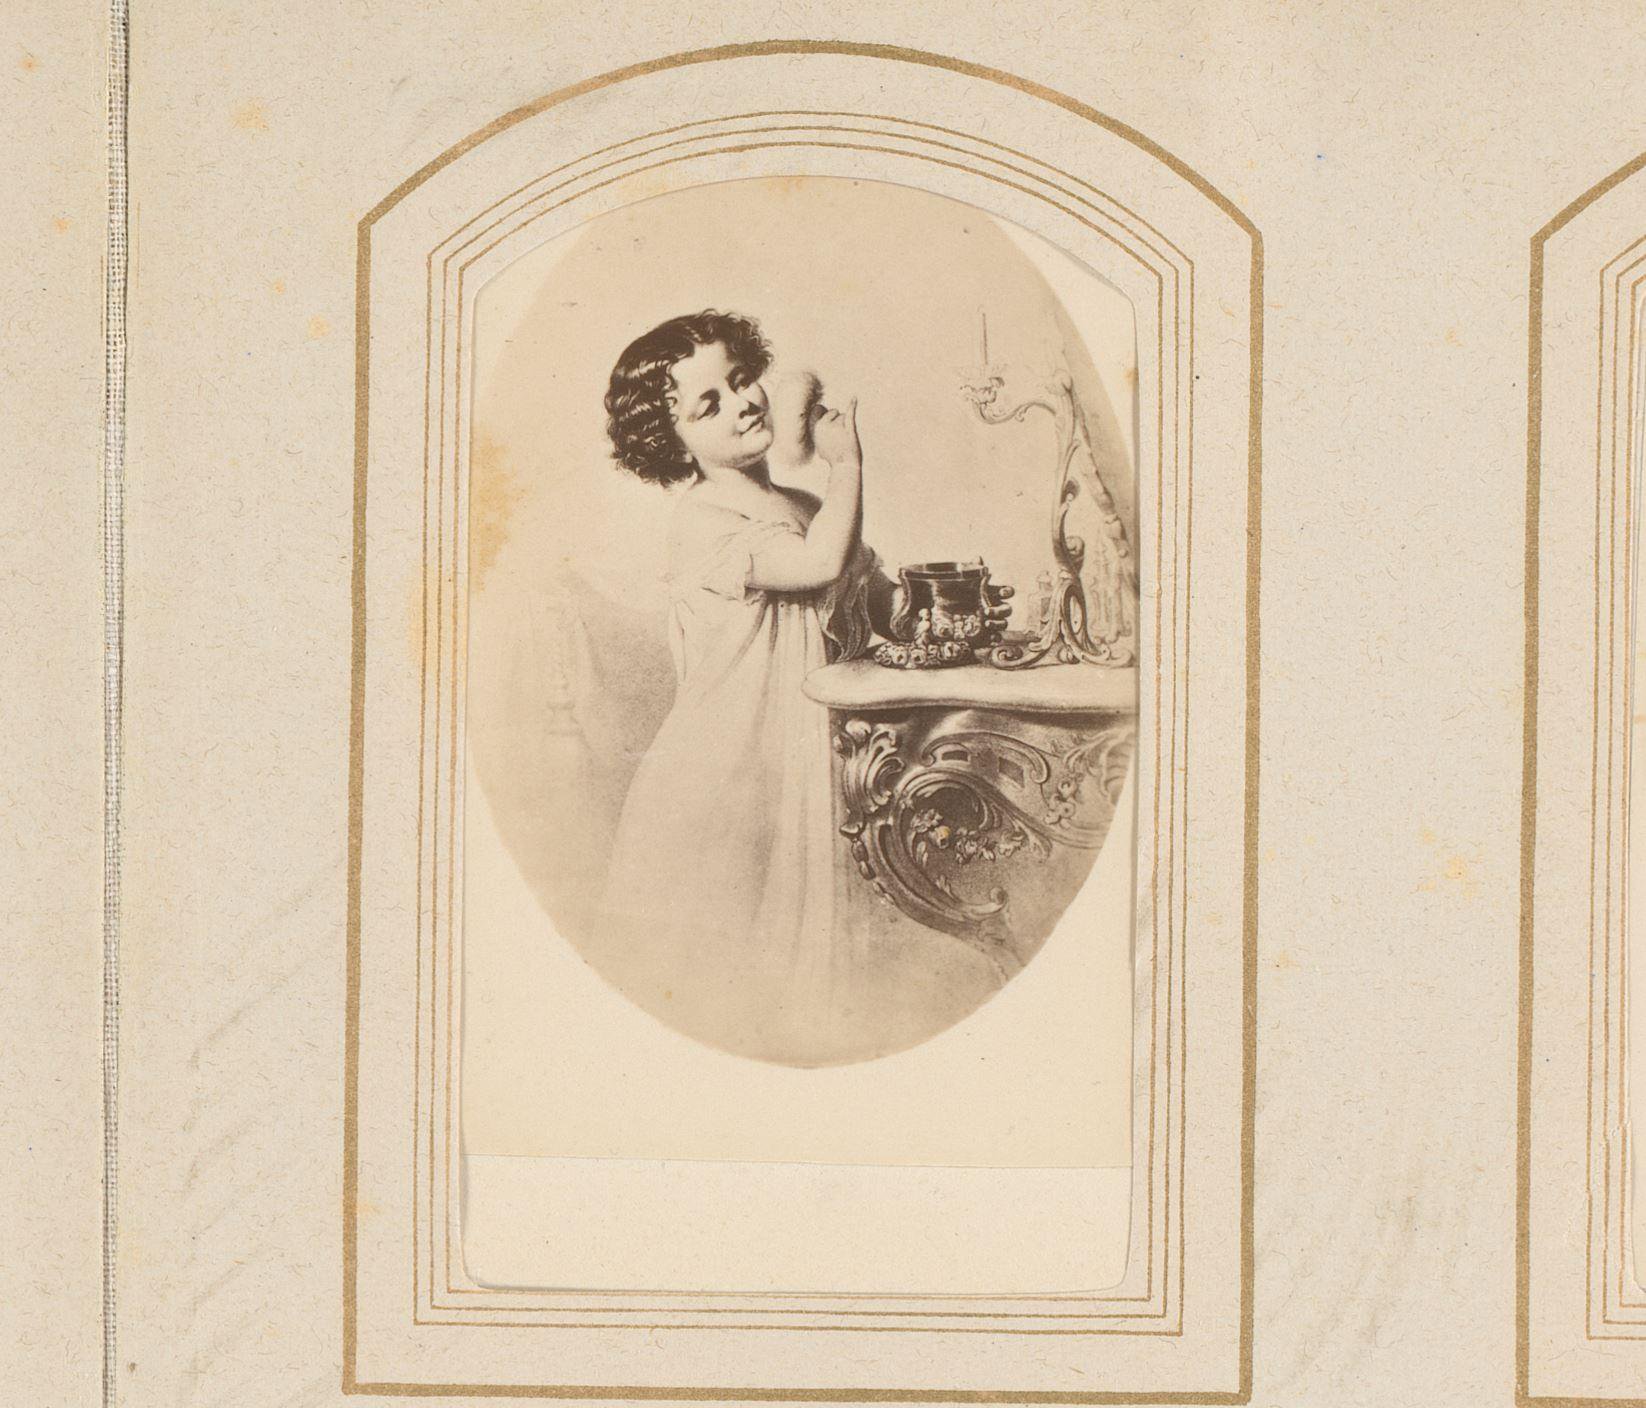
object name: album leaf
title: Fotoreproductie van Coquetterie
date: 1870-1900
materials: cardboard, photographic support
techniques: albumen print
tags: girl (child between toddler and youth), making up, painting, drawing and the graphic arts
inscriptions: annotation: ‘Eitelkeit’, inscription: ‘5. Buhler/Eitelkeit/ Cocquetterie’